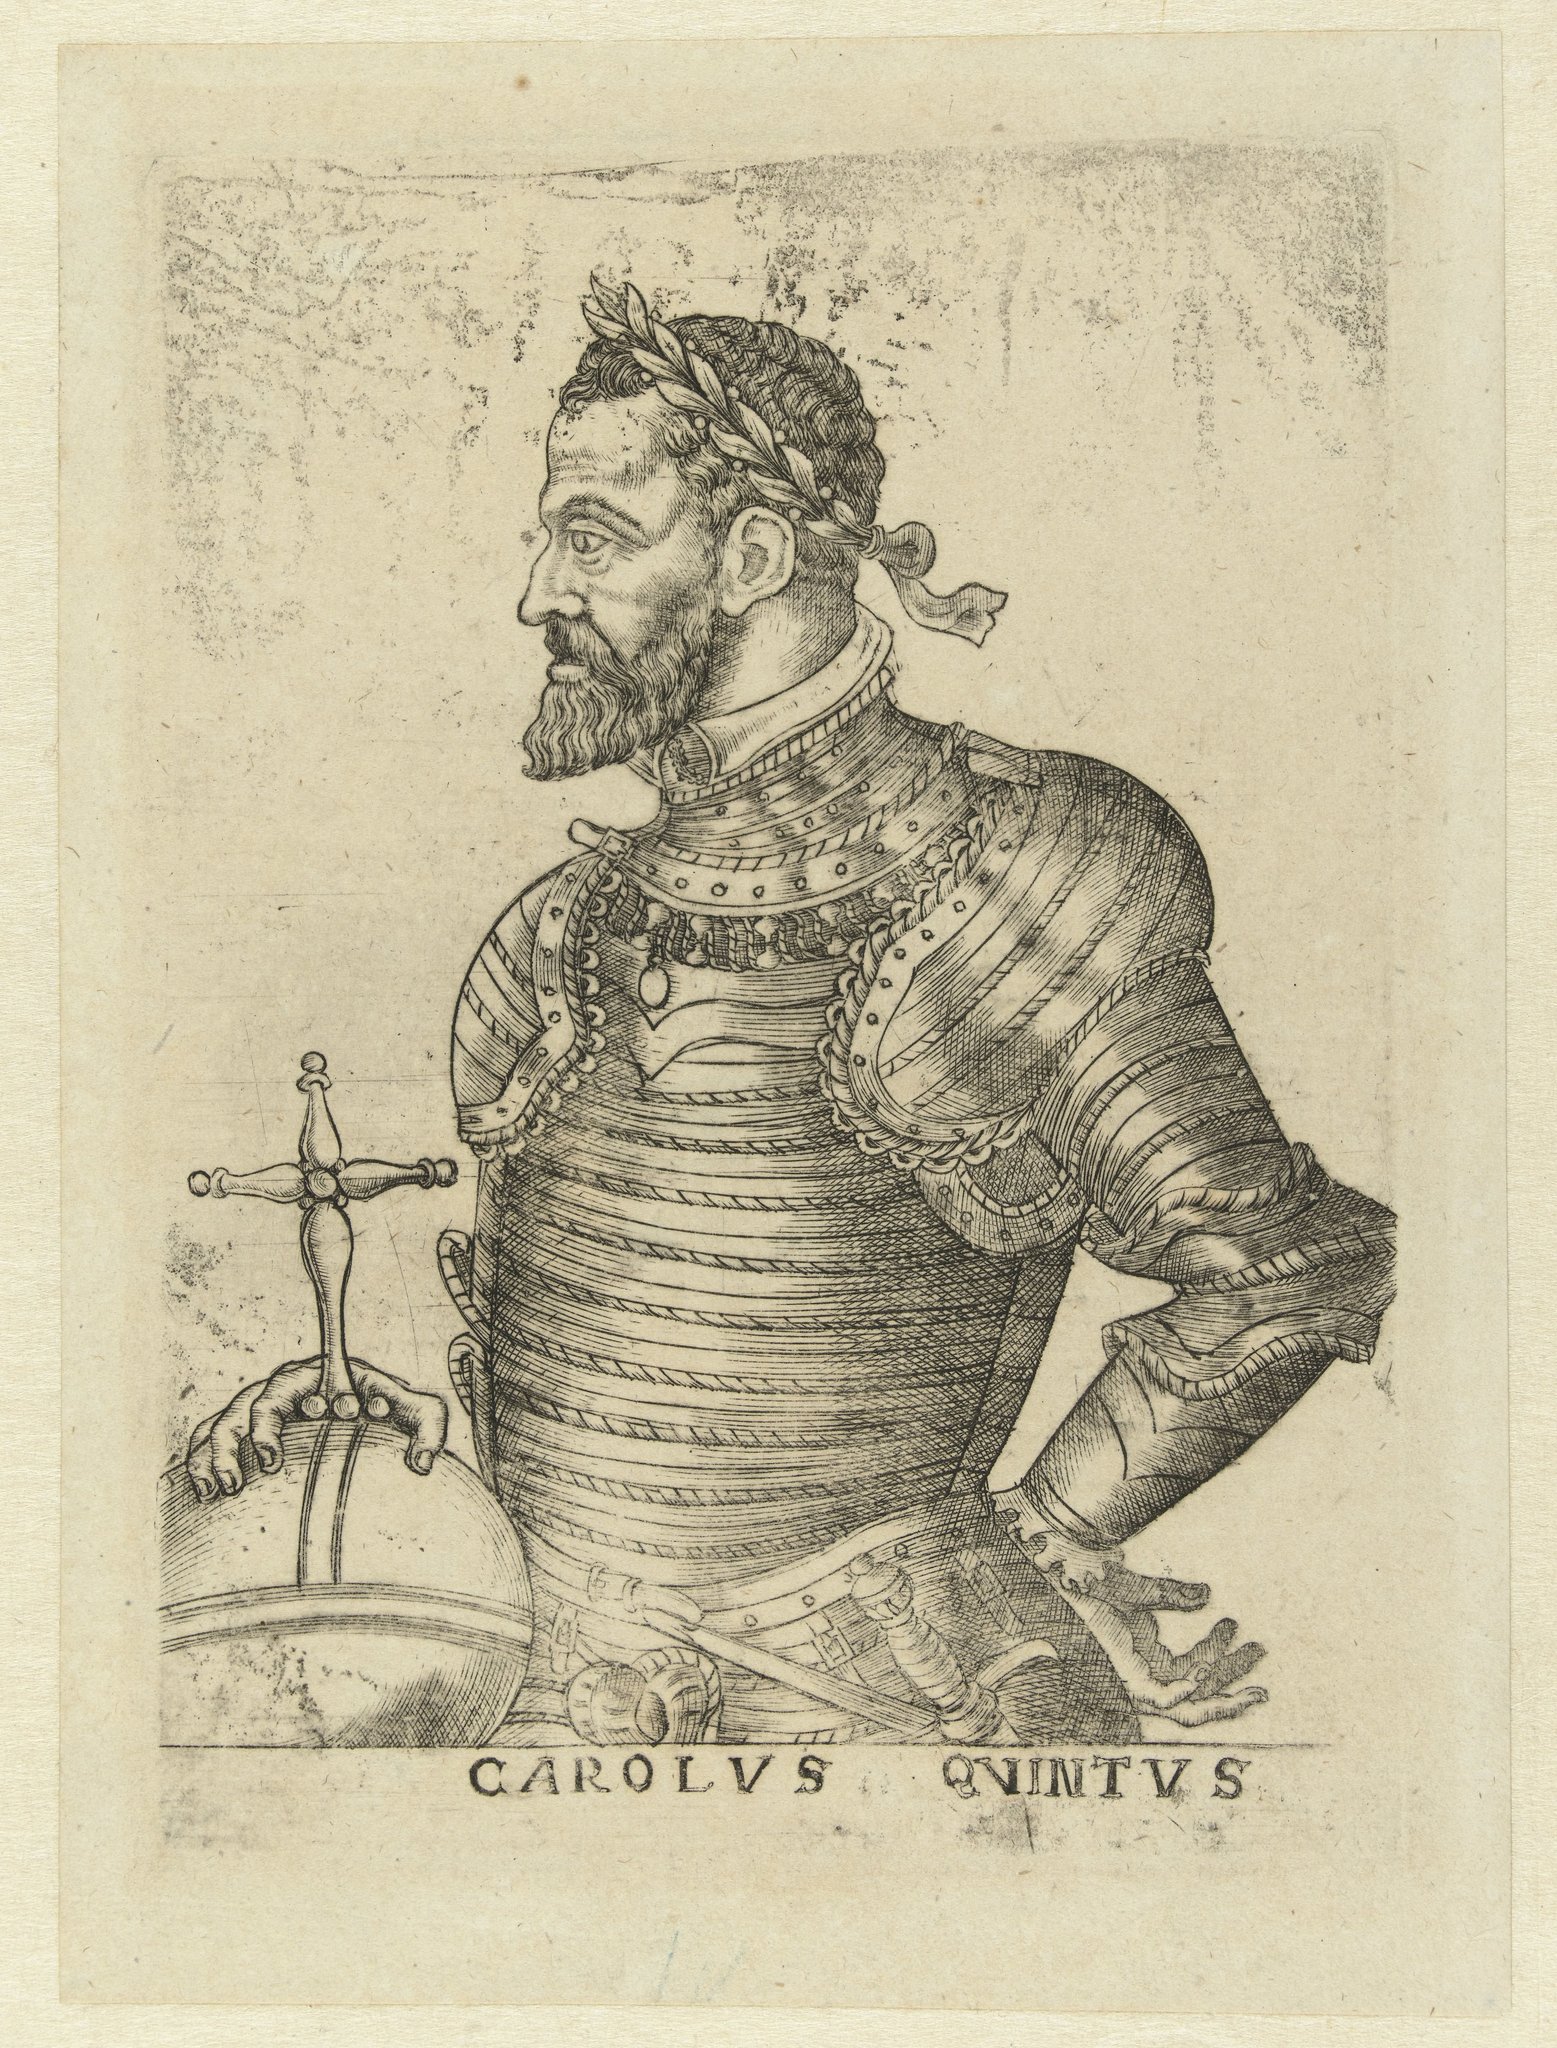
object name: print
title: Carolus Quintus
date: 1510-1609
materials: paper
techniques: etching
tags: charles v (holy roman emperor and king of spain)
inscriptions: collector's mark: Lugt 2228a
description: Portret van keizer Karel V in harnas en met lauwerkrans.